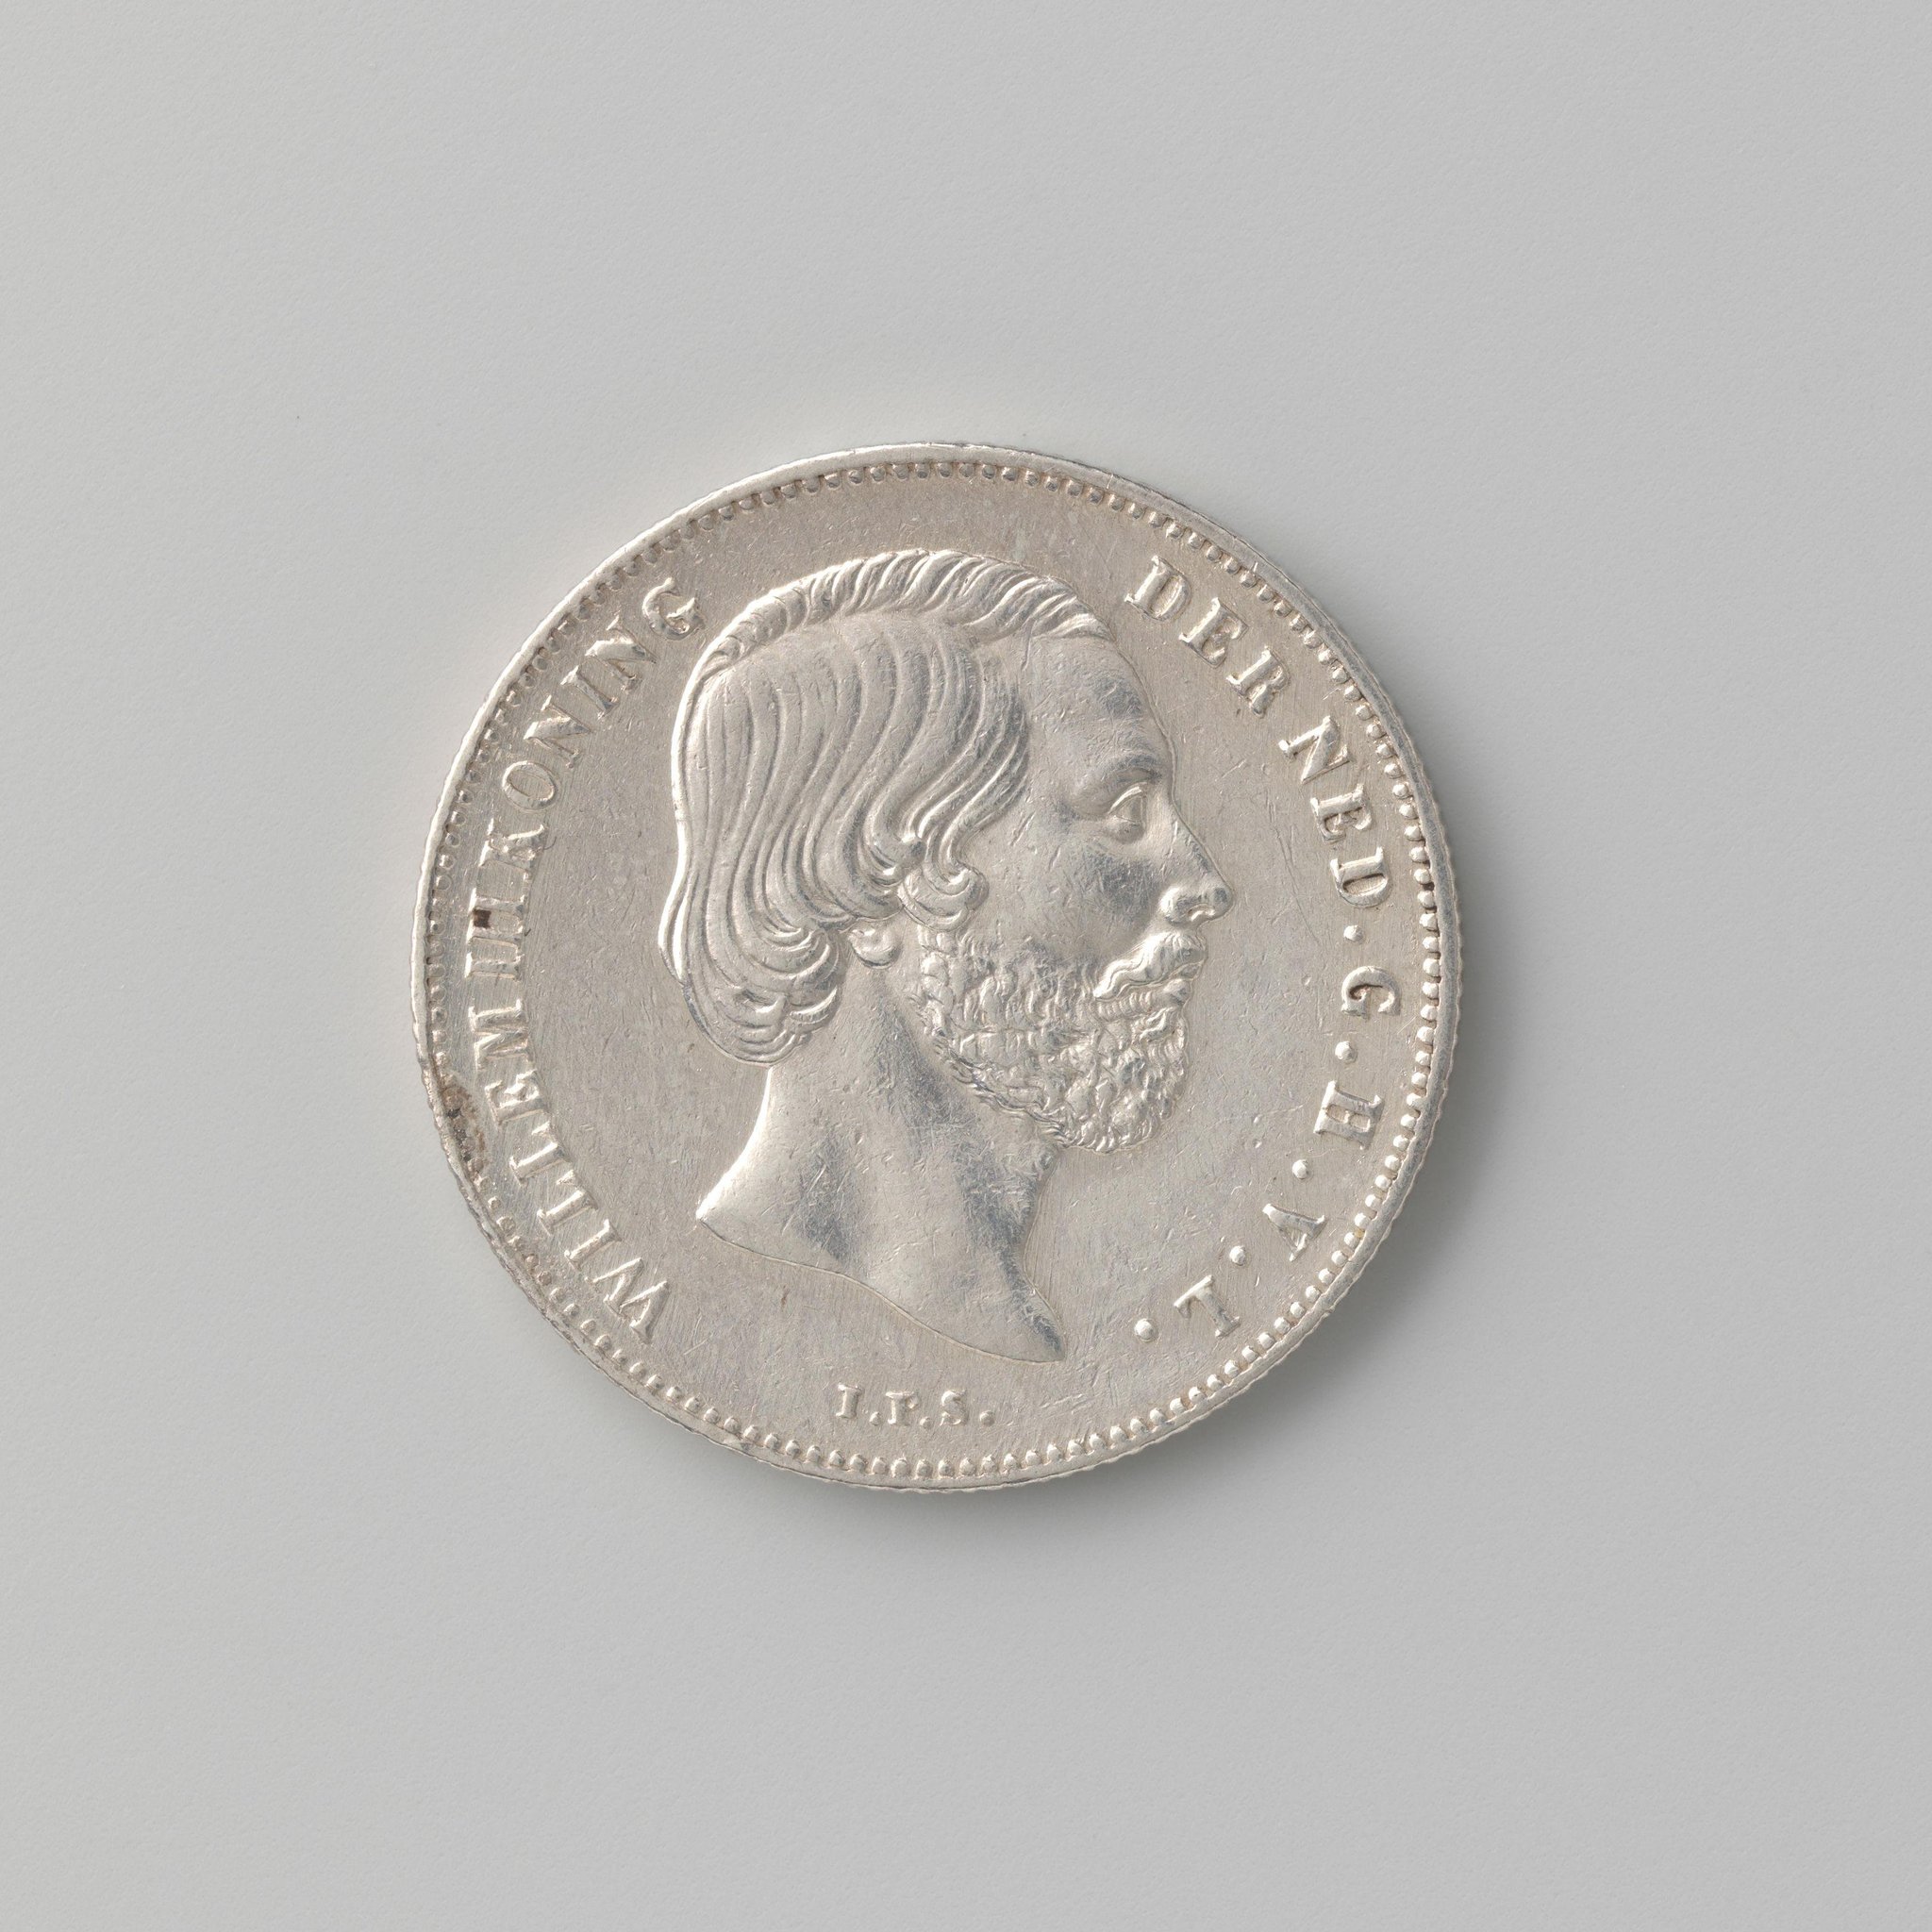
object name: coin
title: Halve gulden van het Koninkrijk der Nederlanden op naam van koning Willem III, moderne verzamelaarsvervalsing met aangepast jaartal.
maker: johannis petrus schouberg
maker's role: die cutter, draughtsman, print maker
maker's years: 1798-1864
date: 1853-2000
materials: silver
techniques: soldering, striking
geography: utrecht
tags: brussels, willem iii (koning der nederlanden)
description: Halve gulden uit de tijd van koning Willem III, met een 3 over een ander cijfer gesoldeerd.